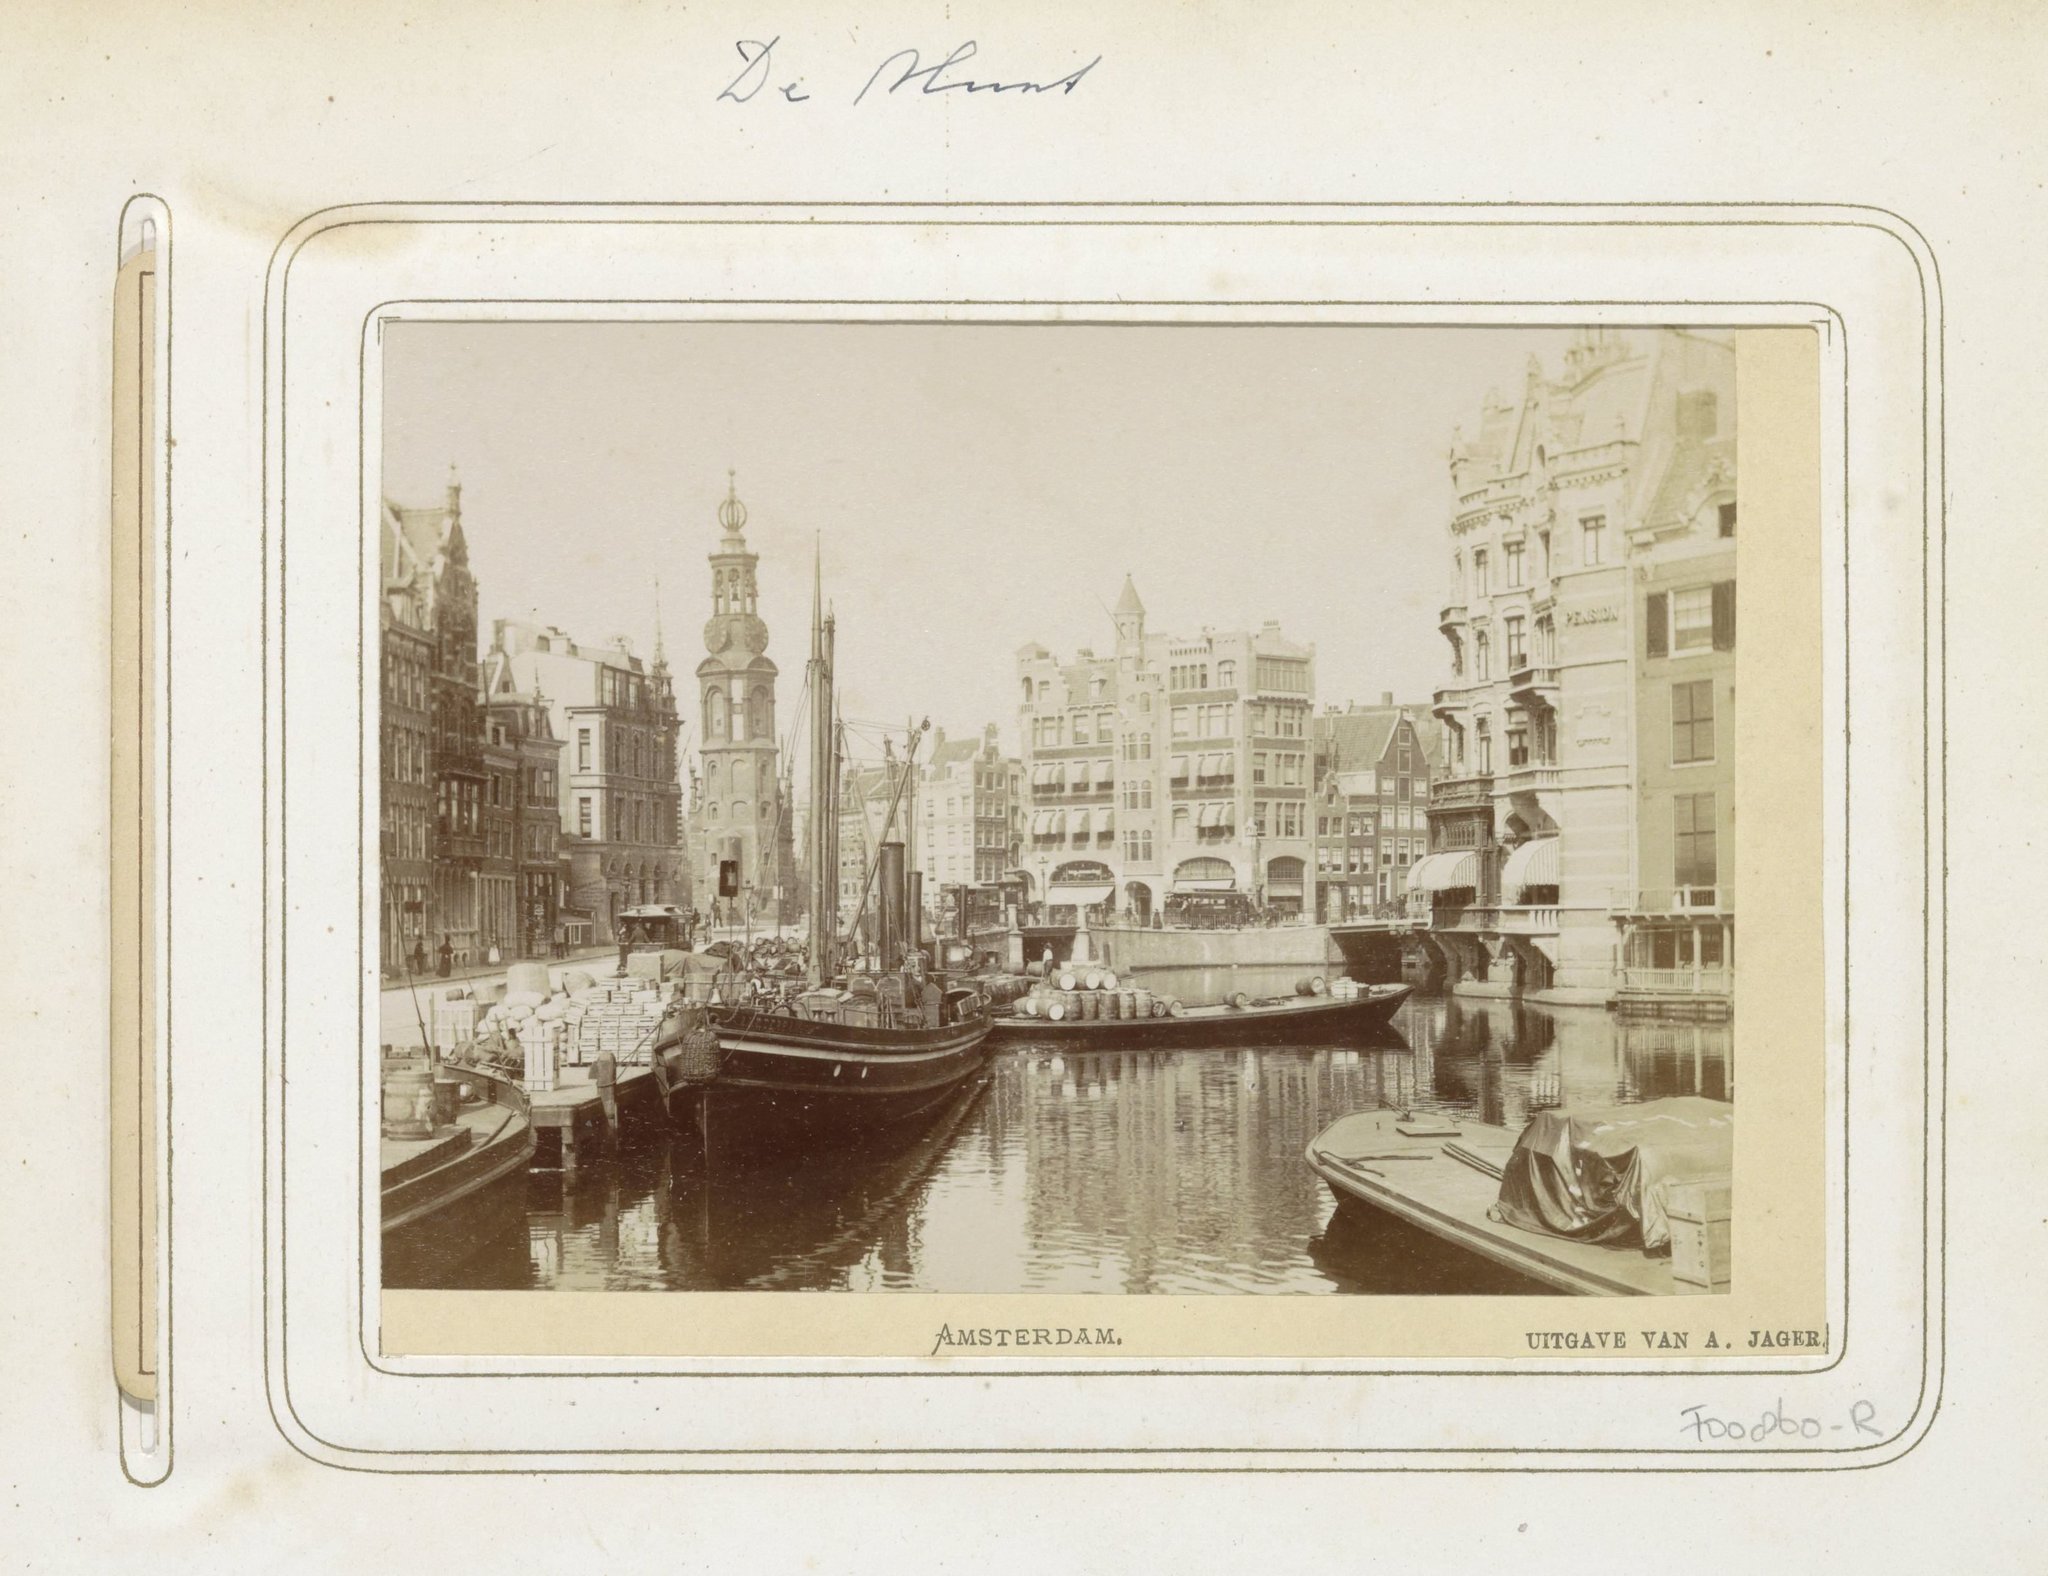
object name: cabinet photograph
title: De Amstel. Amsterdam. Uitgave van A. Jager.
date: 1877-1890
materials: cardboard, paper, photographic support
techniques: albumen print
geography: amsterdam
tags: freight vessel, canals, waters (in city), façade (of house or building), city-gate, prospect of city, town panorama, silhouette of city, amsterdam